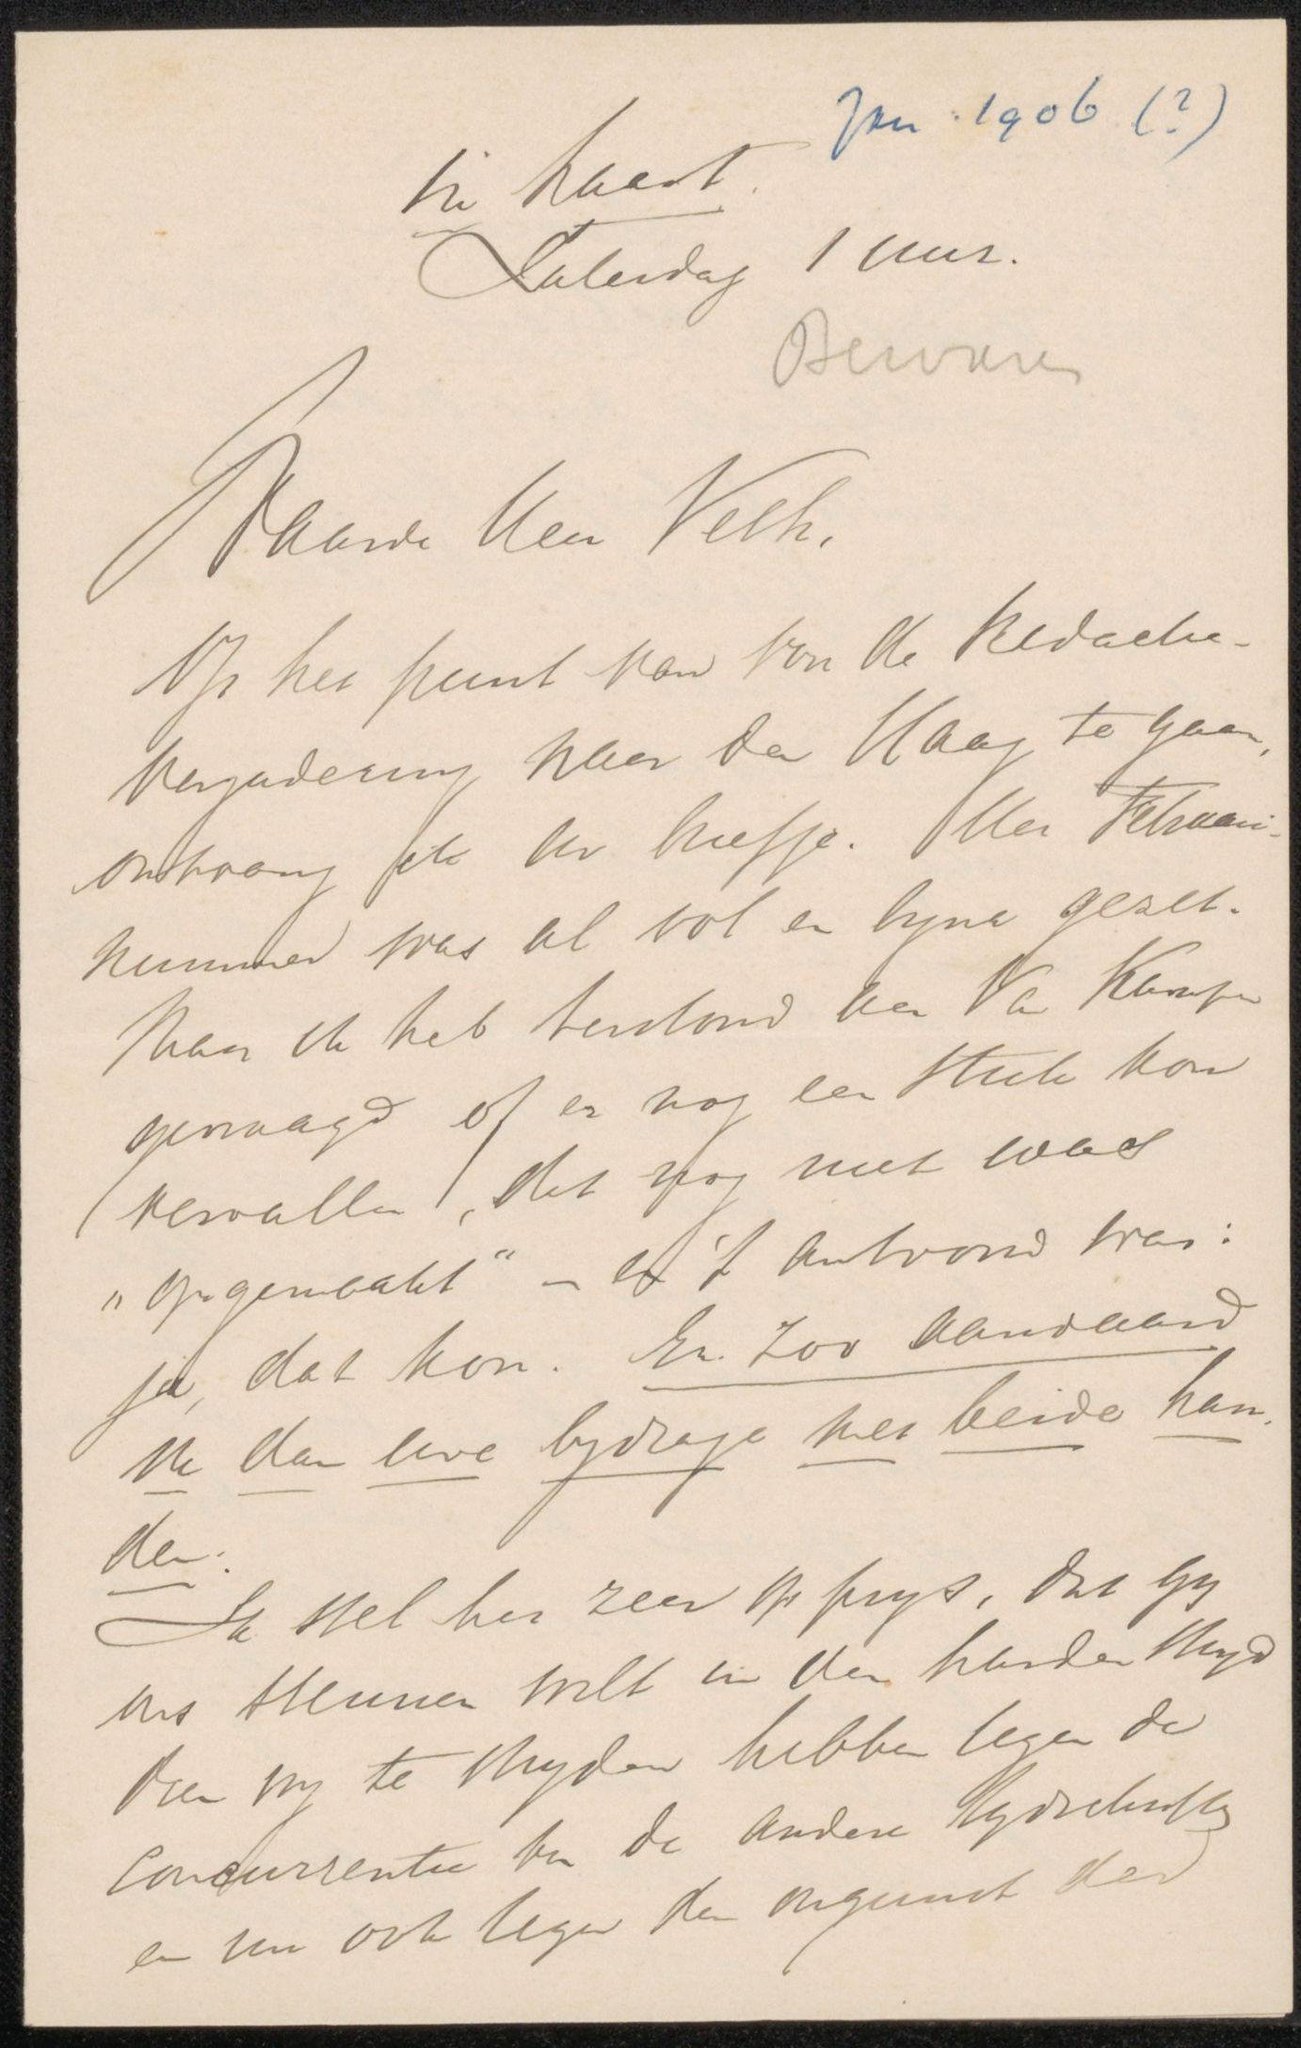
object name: letter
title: Brief aan Jan Veth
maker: jacob nicolaas van hall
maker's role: politician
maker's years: 1840-1918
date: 1874-1918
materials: ink, paper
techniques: pen, writing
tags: dordrecht, designer, jan veth, leiden, amsterdam, painter, print maker, draughtsman, rembrandt van rijn, printed matter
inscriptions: collector's mark: ‘RPK’, watermark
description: Brief gedateerd Jan 1906 (?) in latere hand.